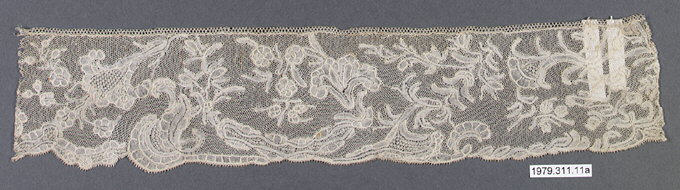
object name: edging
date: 1734-1766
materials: lace, linen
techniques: lace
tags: flowers